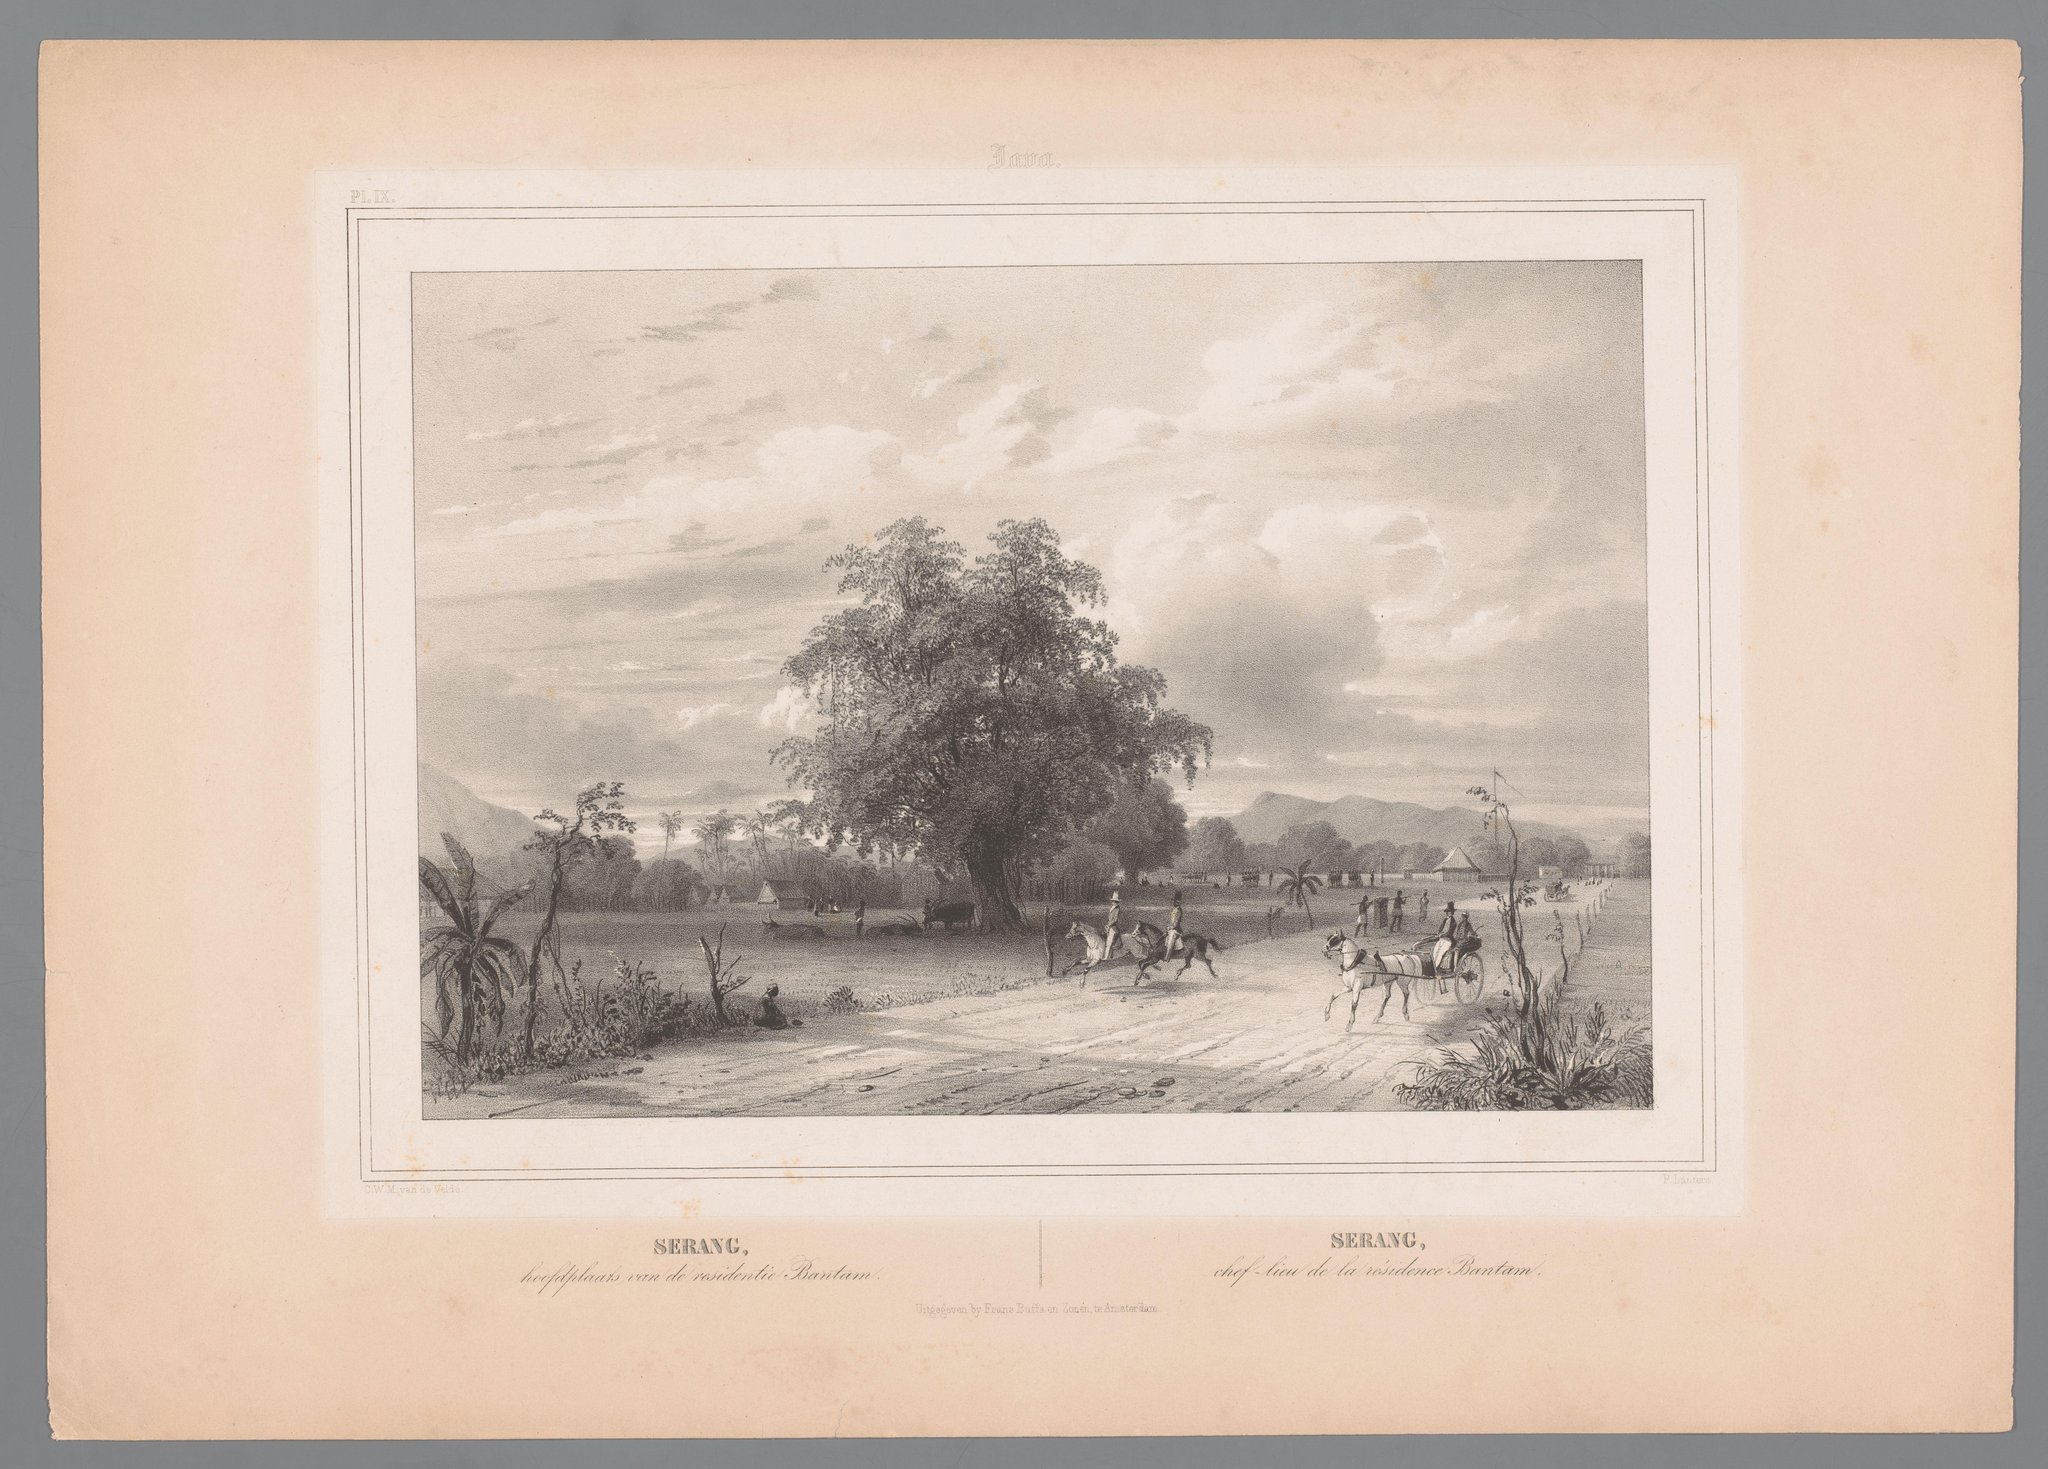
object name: print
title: Gezigten uit Neêrlands Indië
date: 1847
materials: paper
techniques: lithograph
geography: amsterdam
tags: riding a horse, ass, or mule; rider, horseman, city-view in general; 'veduta' (+ city(-scape) with figures, staffage), public road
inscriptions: inscription: ‘6; 2487-1909’, label: ‘Koloniaal Instituut - Amsterdam; No. 207; Doos No. 3’, collector's mark: Lugt 2228, stamp: ‘Koloniaal Museum Haarlem’